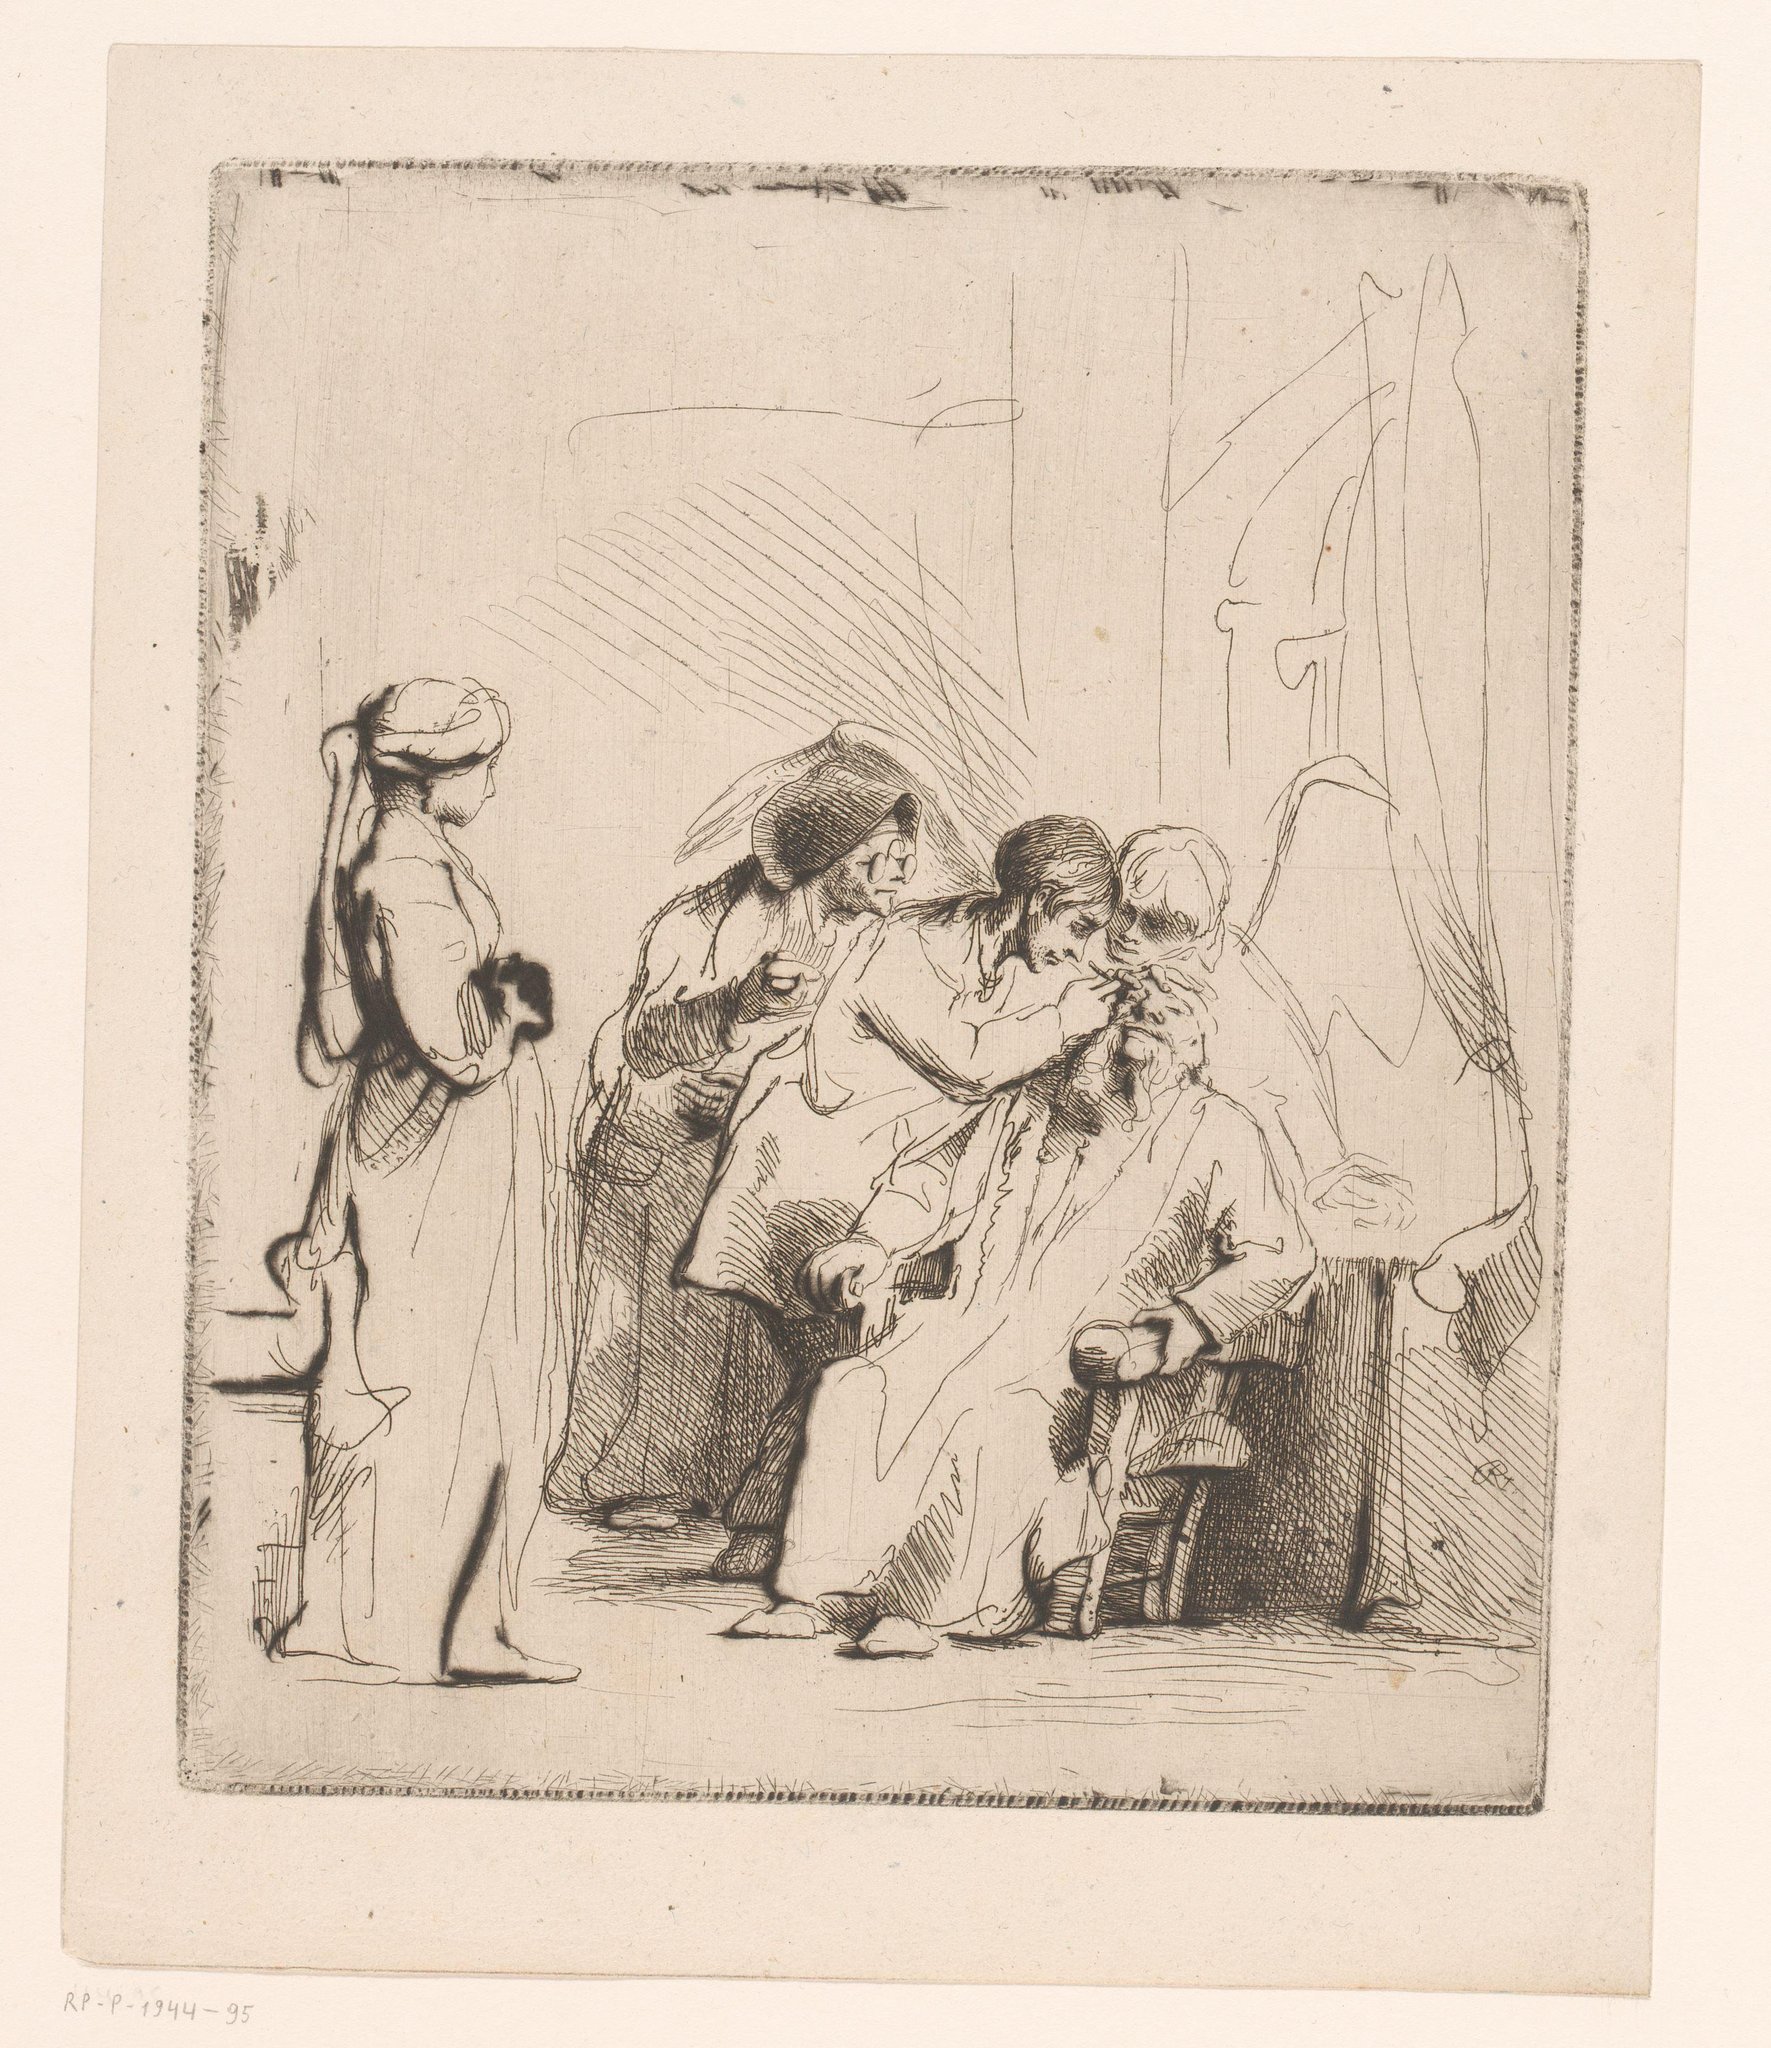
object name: print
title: Genezing van de ogen van Tobit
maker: ignace-joseph de claussin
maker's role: print maker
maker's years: 1766-1844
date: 1805-1844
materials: paper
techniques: drypoint, engraving, etching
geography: france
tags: the archangel raphael, the healing of tobit: tobias puts the gall of the fish on his father's eyes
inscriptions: collector's mark: Lugt 2228, collector's mark: Lugt 2165